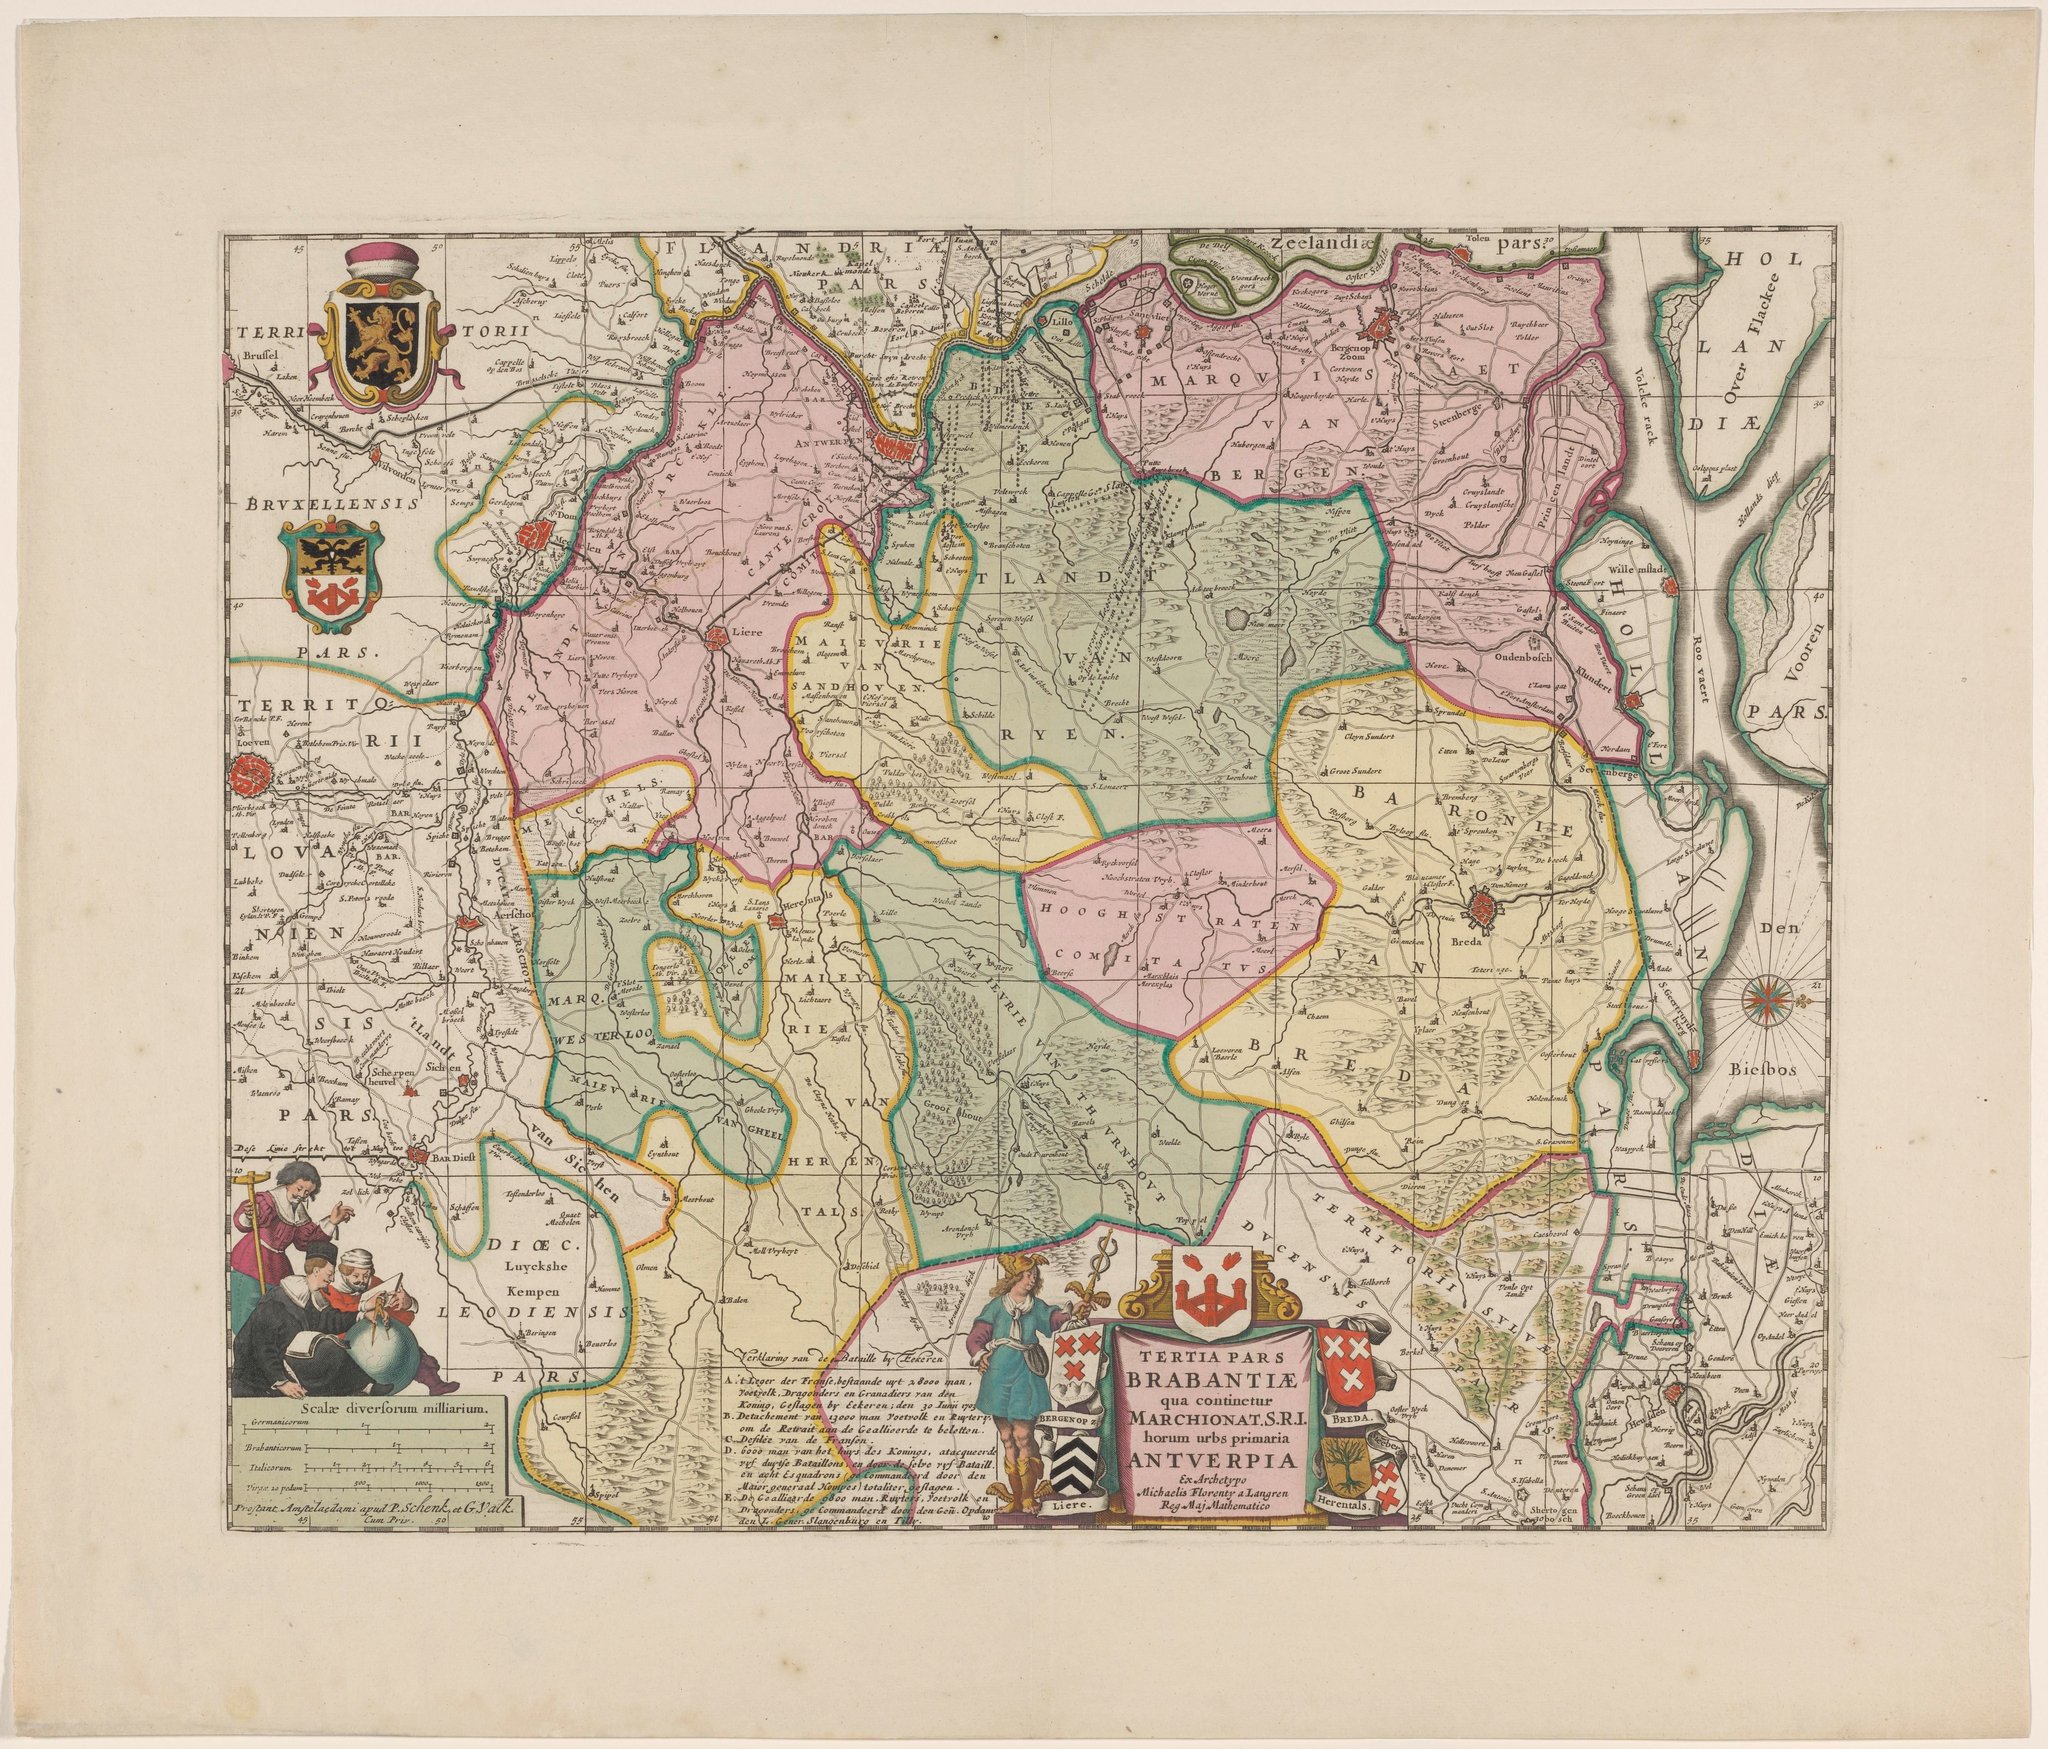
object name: map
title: Tertia pars Brabantiae qua continetur Marchionat (...)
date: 1638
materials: paper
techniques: engraving, etching, hand coloring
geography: amsterdam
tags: coat of arms (as symbol of the state, etc.) (+ city; municipal), maps of separate countries or regions, (story of) mercury (hermes), globe, coat of arms (as symbol of the state, etc.) (+ province; provincial), brabant, antwerp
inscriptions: collector's mark: Lugt 195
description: Kaart van het kwartier van Antwerpen, één van de vier kwartieren waarin het hertogdom Brabant is verdeeld. Onder, Rechts van het midden, de titelcartouche. Links van de titelcartouche een legenda A-E met een verklaring van de Slag bij Ekeren. Boven op de titelcartouche het wapen van de stad Antwerpen, links de wapens van Bergen op Zoom en Lier, rechts van Breda, Herentals en nogmaals van Breda. Linksboven in de kaart het wapen van Brabant, met daaronder het wapen van Antwerpen. Linksonder een cartouche met vier schaalstokken. De kaart is voorzien van een coördinaten-net en een gradenverdeling.